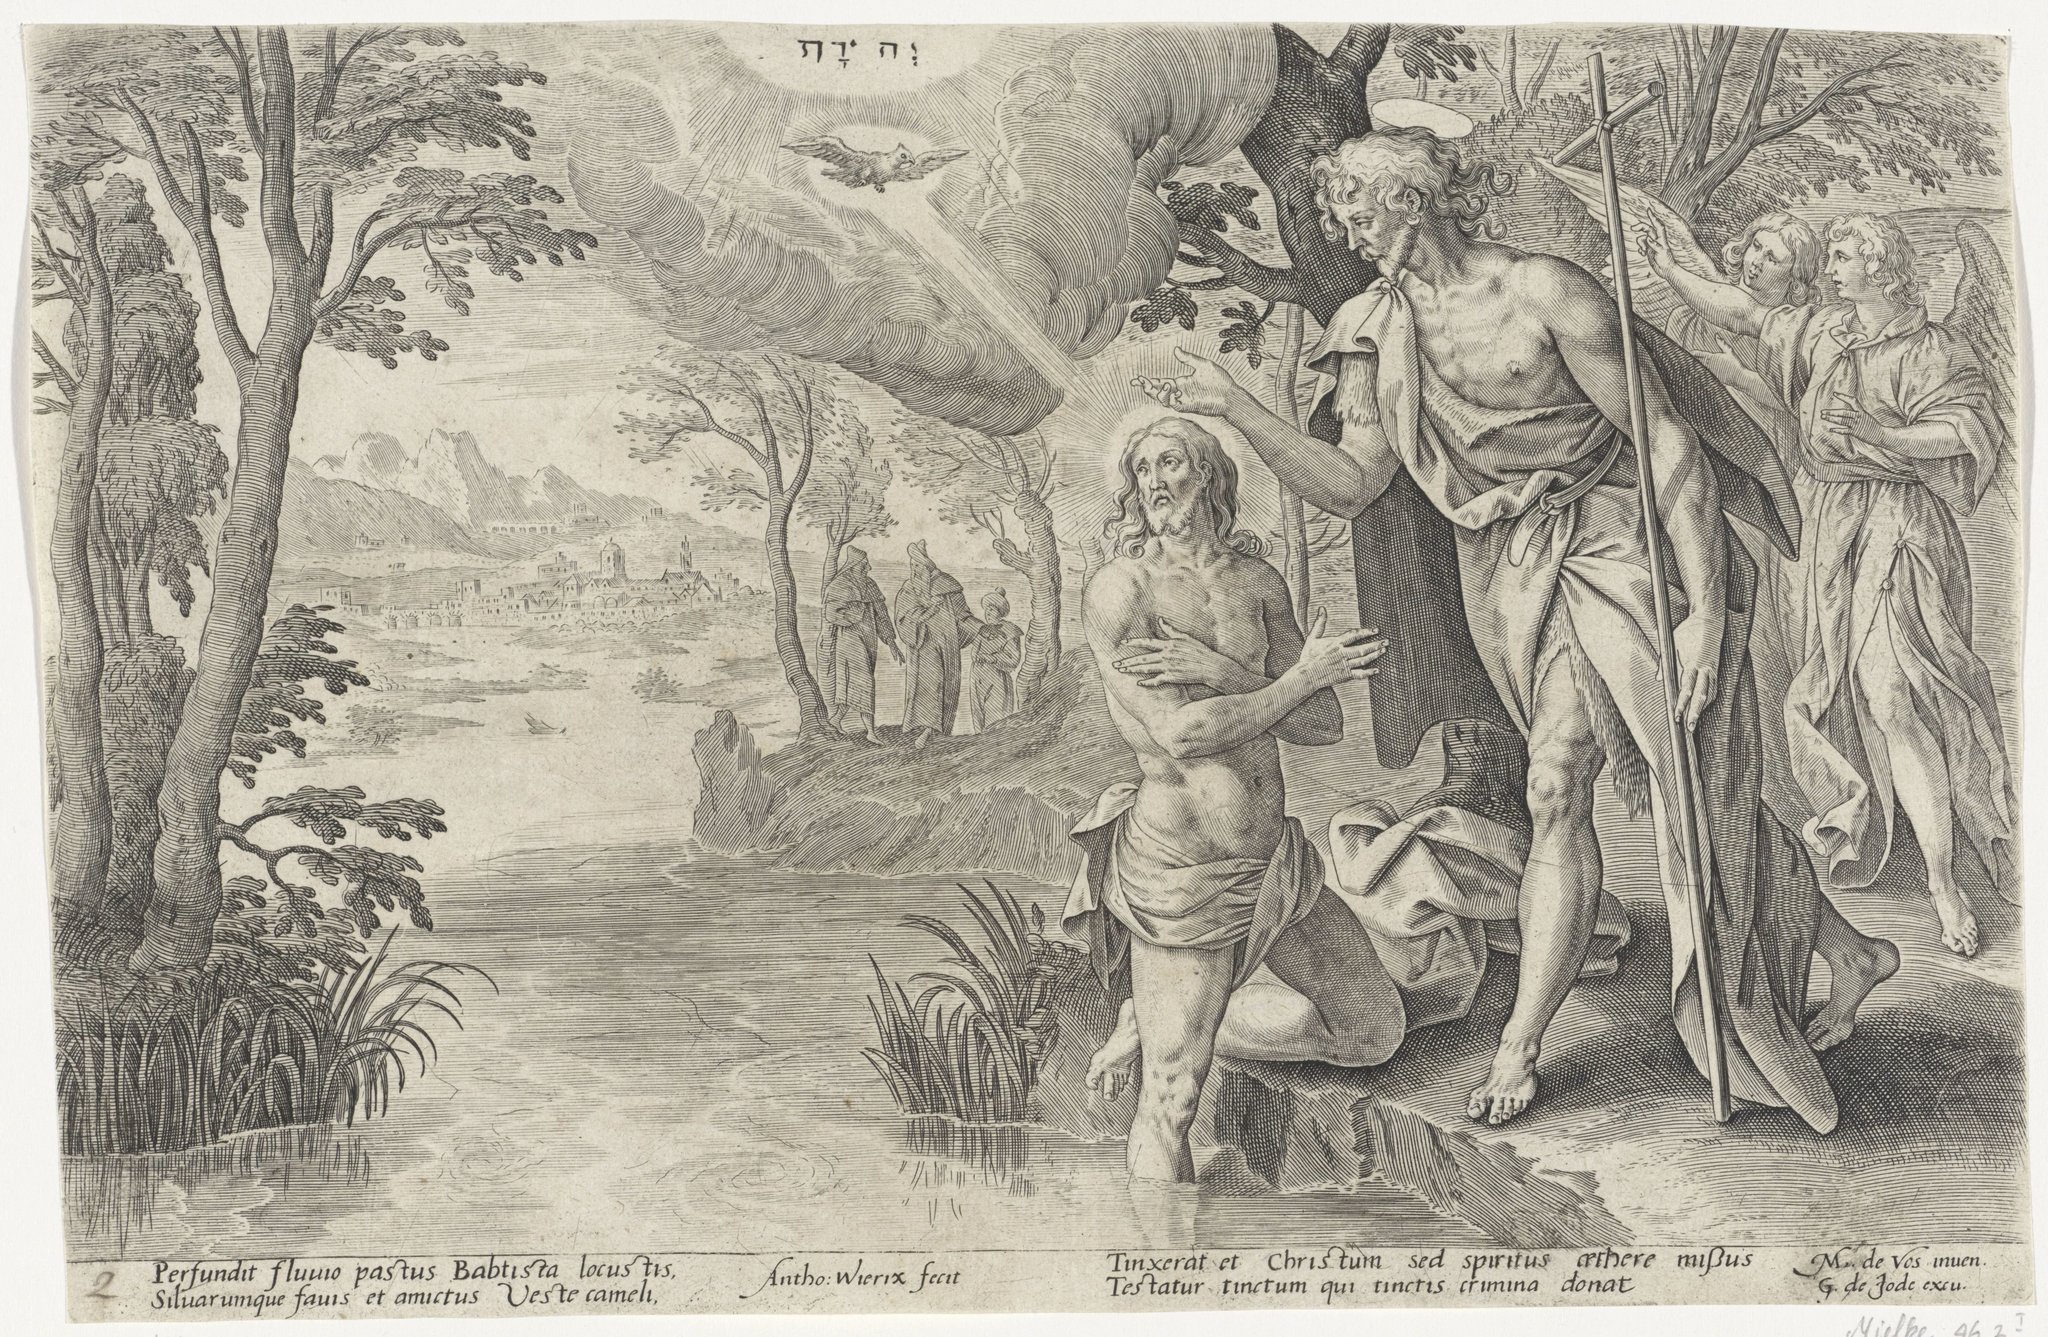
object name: print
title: Doop van Christus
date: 1585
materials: paper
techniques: engraving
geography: antwerp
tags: baptism of christ in the river jordan: john the baptist pouring out water on christ's head: the holy ghost descends, tetragram (in roman or hebrew script) ~ symbol of god the father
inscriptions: number: ‘2’, collector's mark: Lugt 2228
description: Christus wordt door Johannes de Doper, in het bijzijn van twee engelen, in de Jordaan gedoopt. Eén van hen wijst naar het tetragram - symbool van God de Vader - dat aan de hemel is verschenen nadat Christus uit het water omhoog kwam. God in de gedaante van een duif daalt op hem neer. Onder de voorstelling een verwijzing in het Latijn naar de Bijbeltekst in Mat. 3:13.